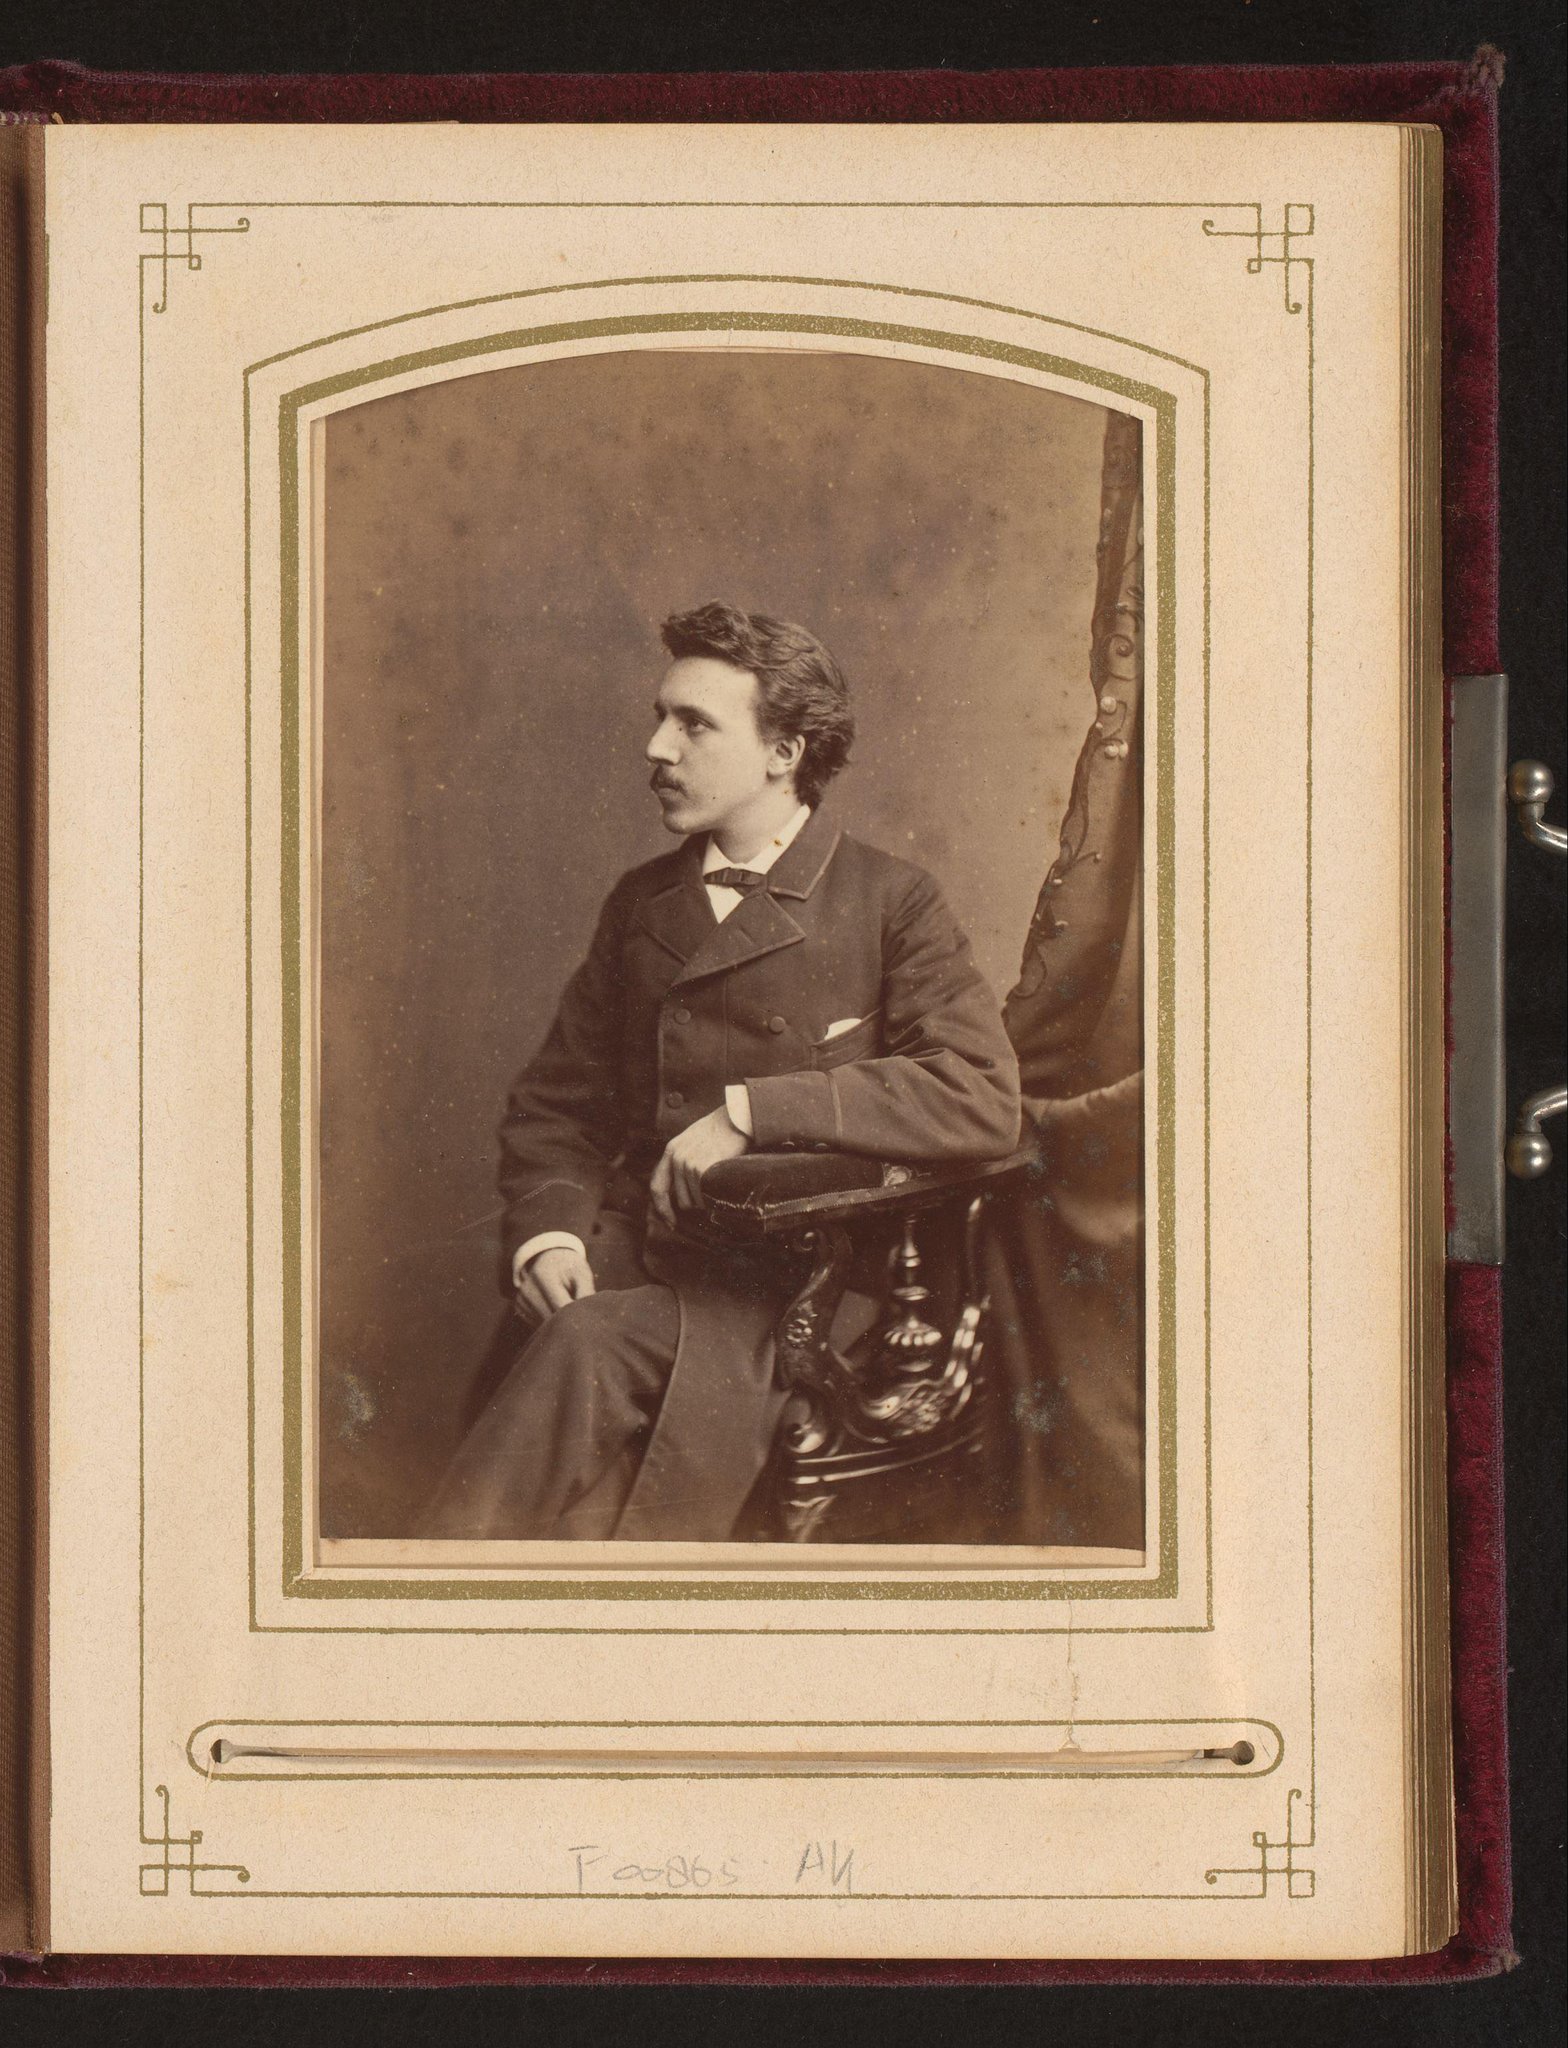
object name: album leaf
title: Portret van een zittende jonge man in lange jas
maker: albert greiner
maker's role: fotograaf, fotostudio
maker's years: 1833-1890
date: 1861-1890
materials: cardboard, photographic support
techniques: albumen print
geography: amsterdam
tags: sitting figure, coat, historical persons, youth, adolescent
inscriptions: inscription: ‘A. Greiner/ Amsterdam.’